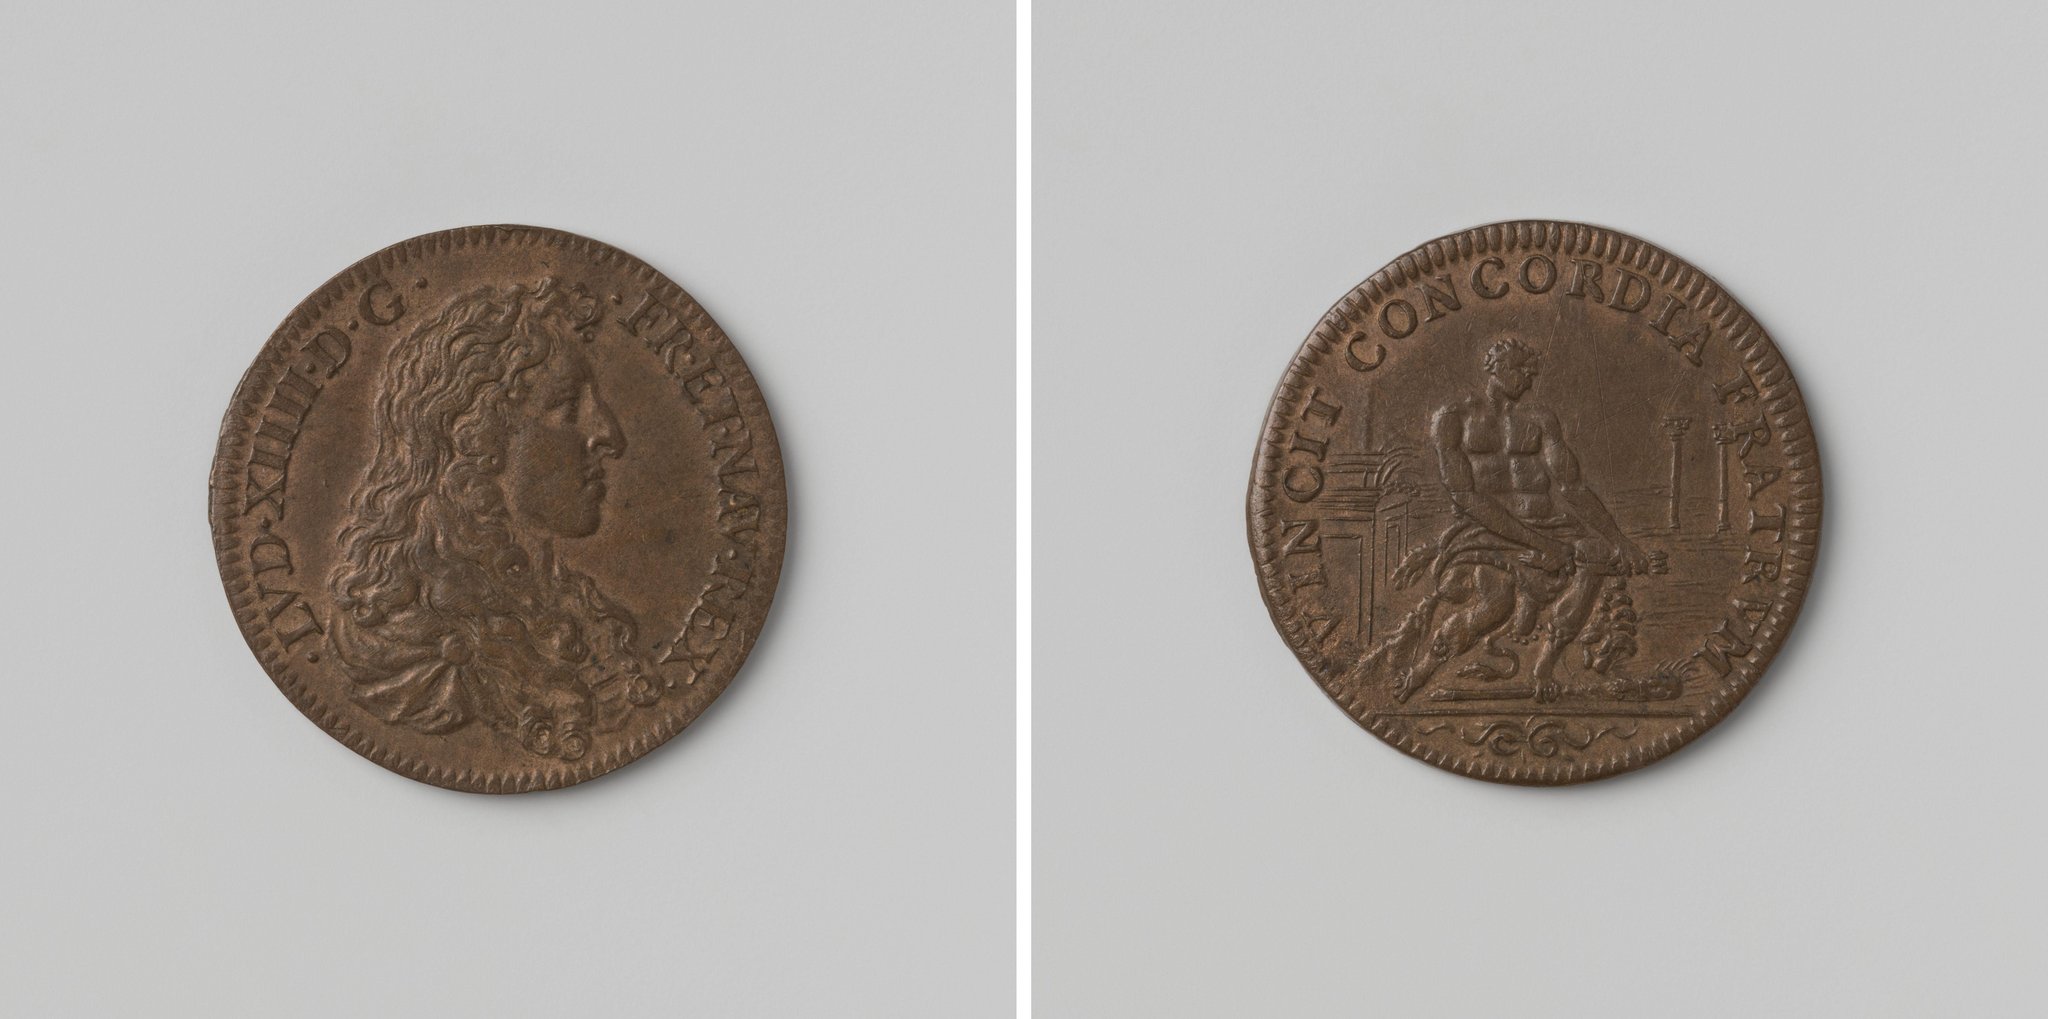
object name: jeton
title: Overwinning op de Triple Alliantie, rekenpenning geslagen ter ere van Lodewijk XIV, koning van Frankrijk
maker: Anonymous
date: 1672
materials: copper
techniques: striking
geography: france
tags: lodewijk xiv (koning van frankrijk), netherlands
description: Koperen penning. Voorzijde: borststuk man binnen omschrift. Keerzijde: Herkules, zittend op leeuwehuid breekt op zijn knie een bundel van drie pijlen door midden binnen omschrift; afsnede: siermotief